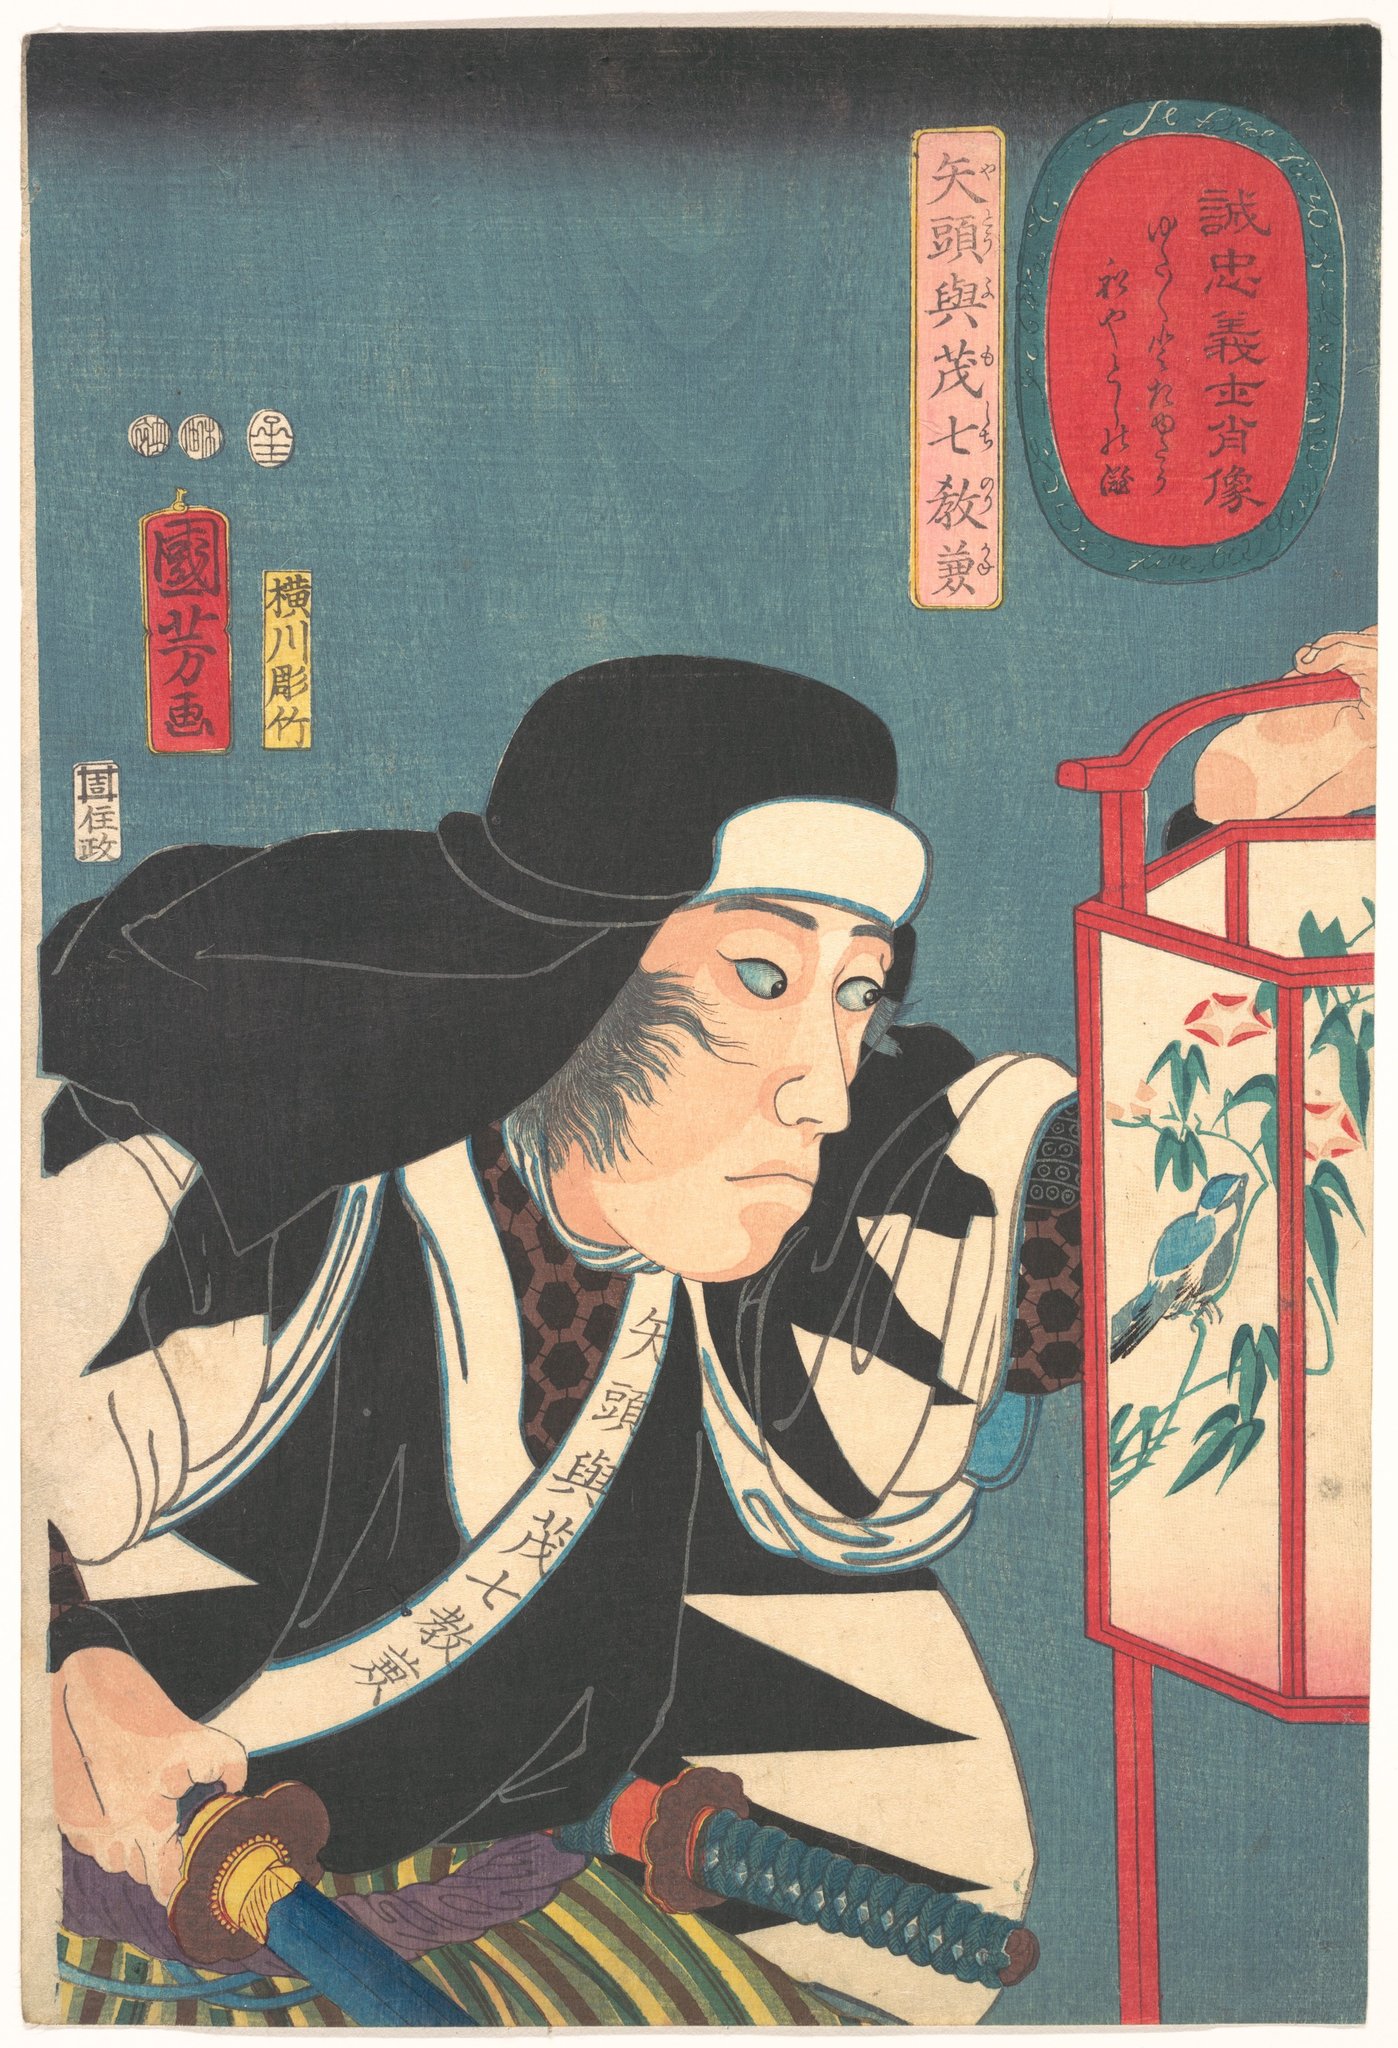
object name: print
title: Portrait of Yato Fumoshichi Norikane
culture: japanese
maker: utagawa kuniyoshi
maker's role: artist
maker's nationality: japanese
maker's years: 1797-1861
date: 1852-1853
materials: ink, paper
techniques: woodblock print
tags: men,portraits